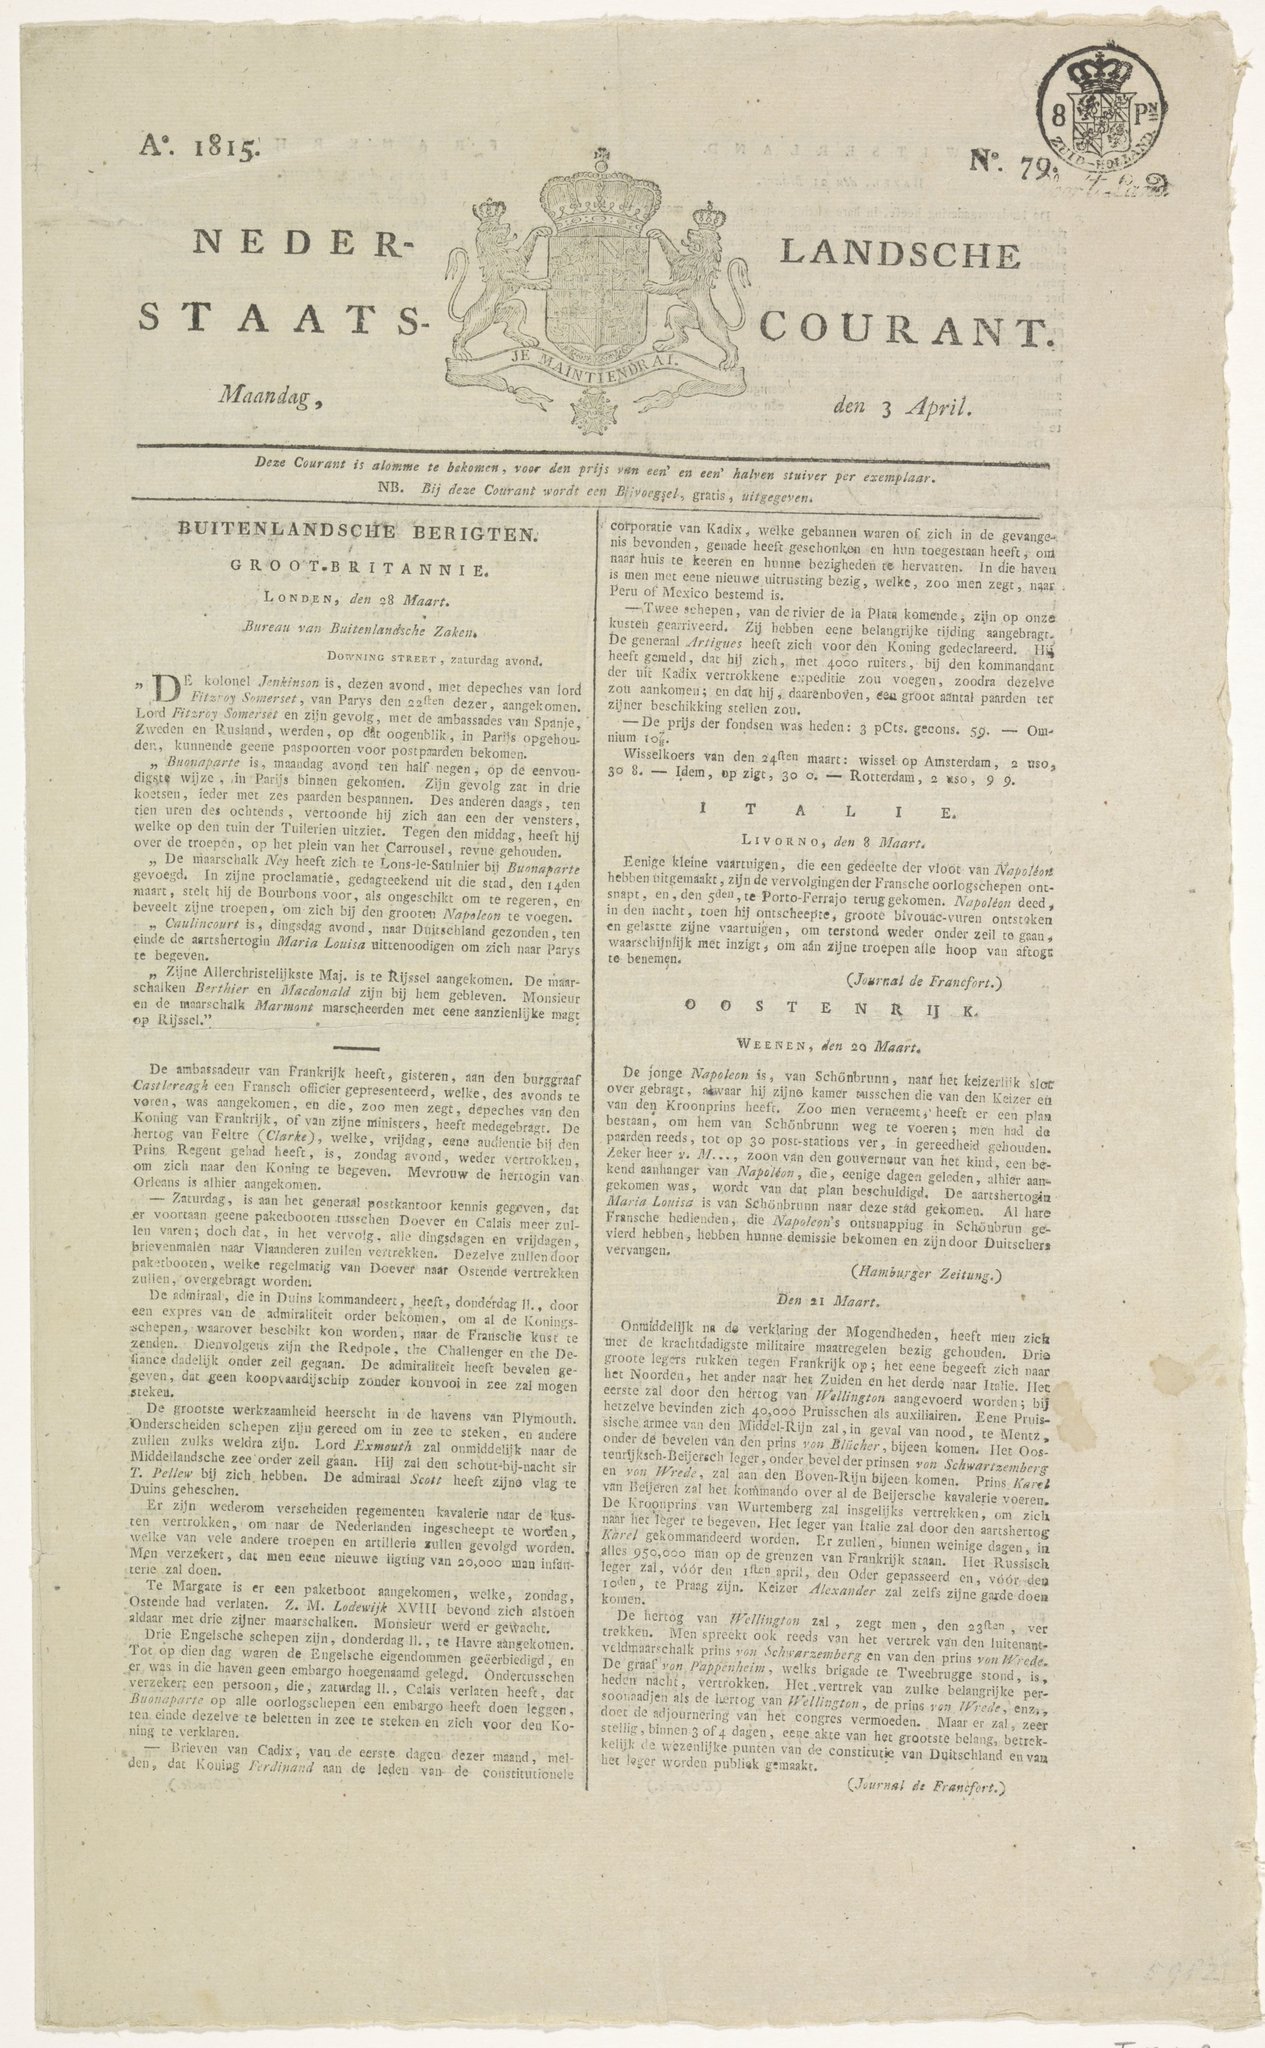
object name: newspaper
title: Nederlandsche Staatscourant. Ao. 1815 No. 79. Maandag, den 3 April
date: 1815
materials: paper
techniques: letterpress printing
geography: the hague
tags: berlin, william i of the netherlands, napoleon i (emperor of the french)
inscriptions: collector's mark: Lugt 2228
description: Aflevering van de Nederlandsche Staatscourant van 3 april 1815, met het nieuws van de intrede op 30 maart te Brussel door koning Willem I en van de strijd tegen Napoleon. Dubbelgevouwen blad bedrukt op alle vier zijden.